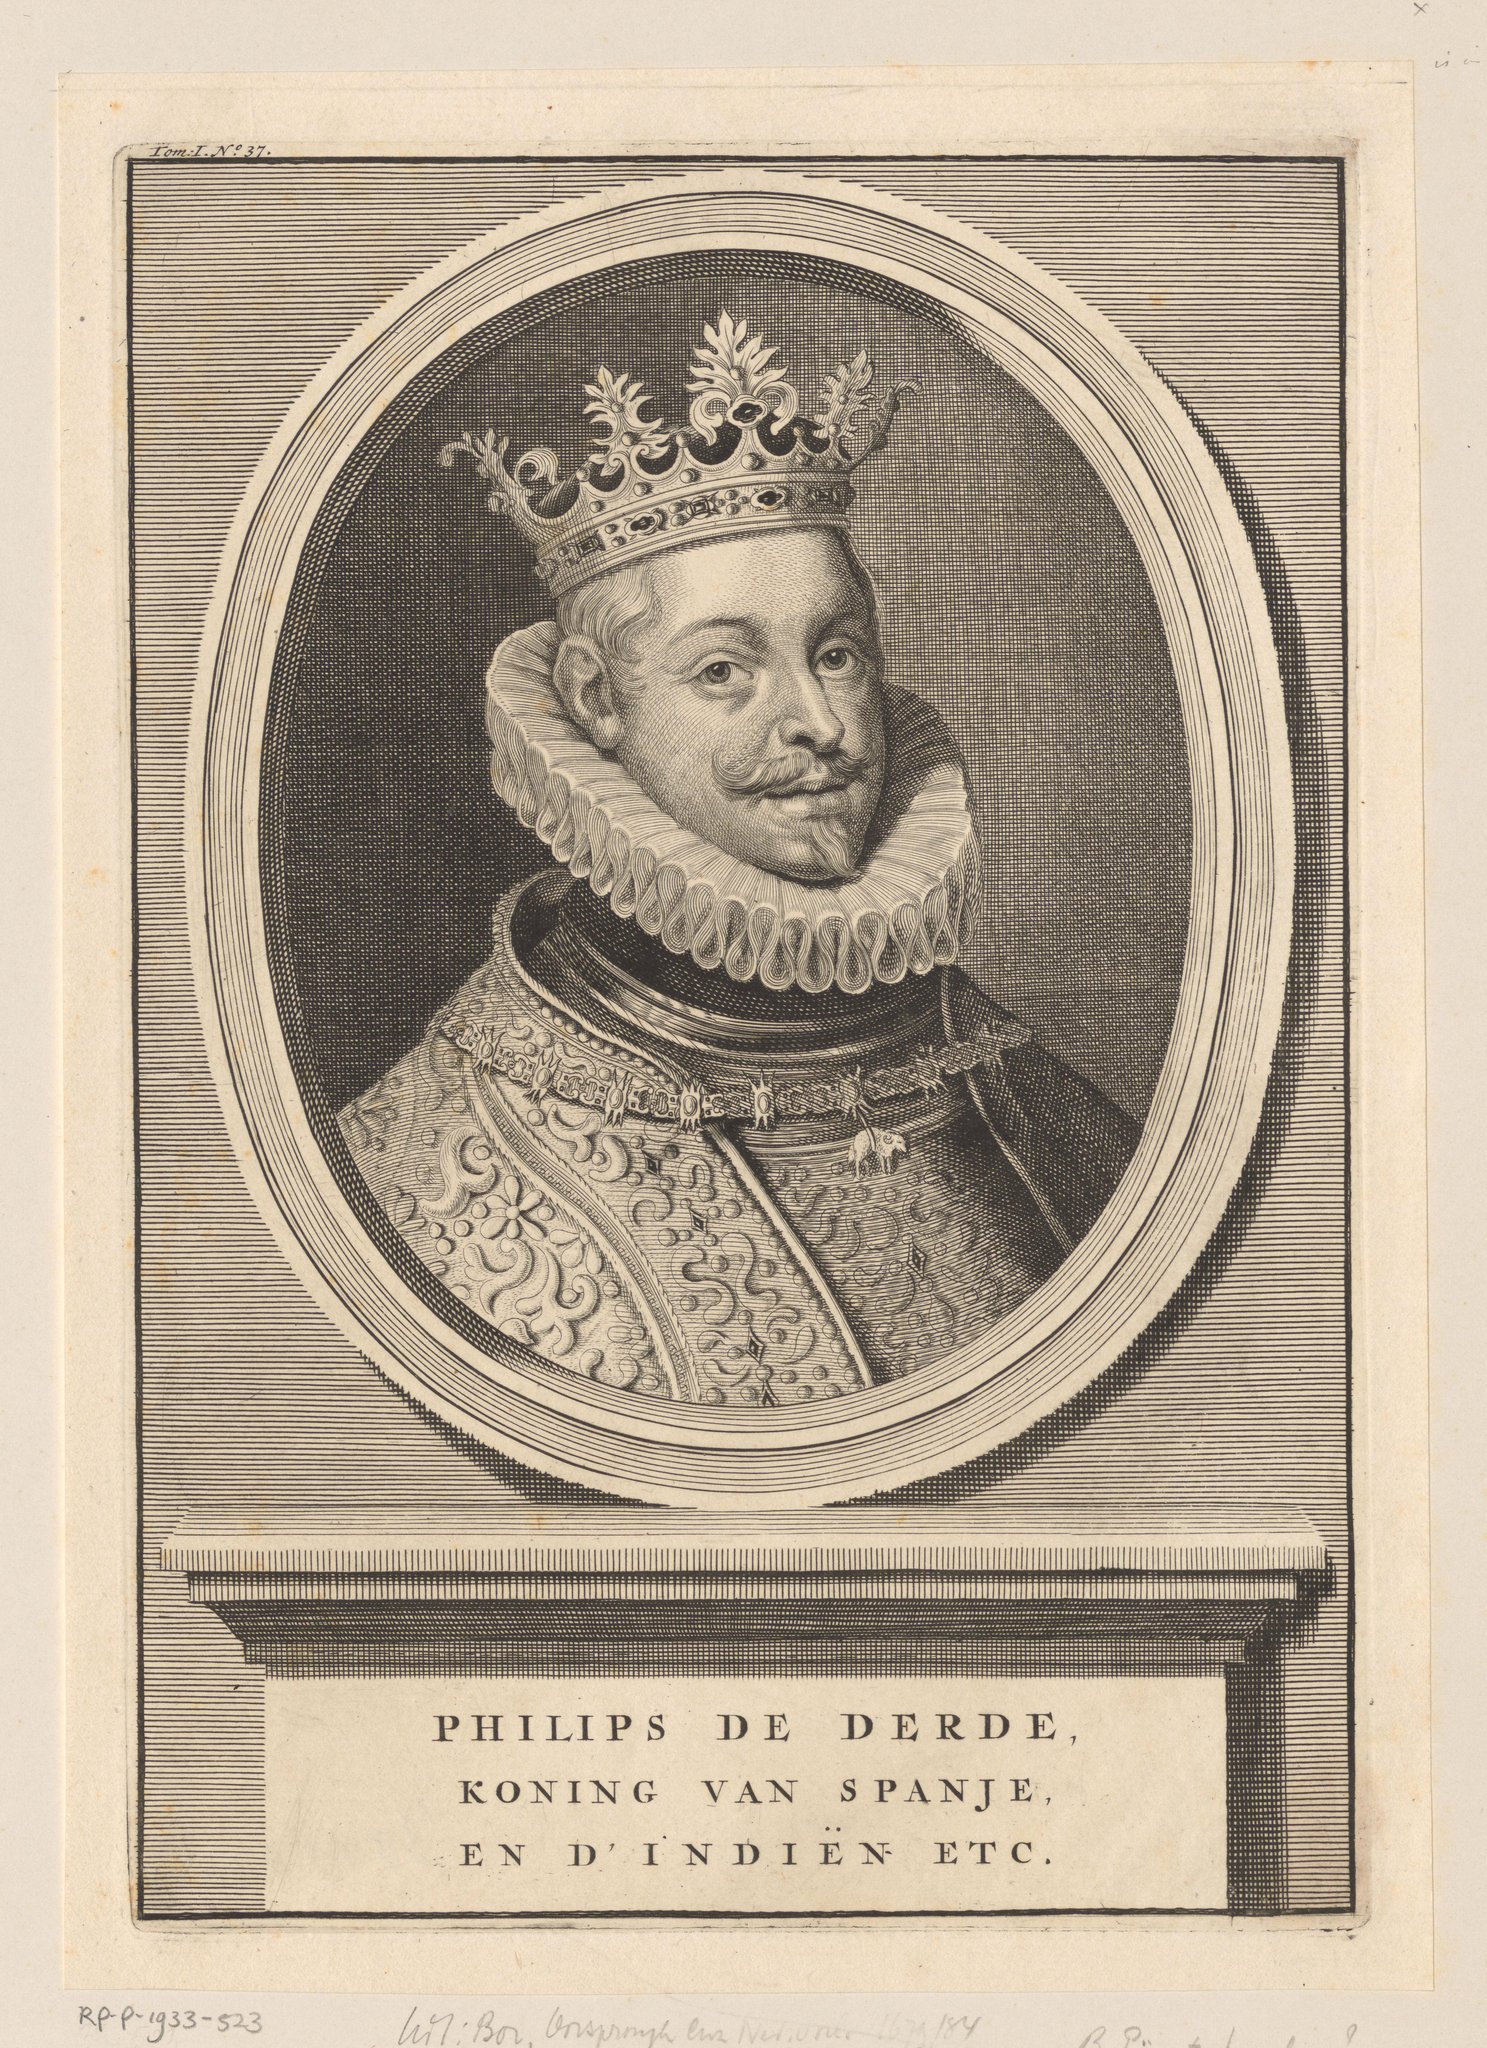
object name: print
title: Portret van Filips III, koning van Spanje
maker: andries vaillant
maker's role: print maker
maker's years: 1655-1693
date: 1730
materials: paper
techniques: engraving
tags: adult man, historical persons, knighthood order of the golden fleece, insignia and symbols of sovereignty (crown, diadem, sceptre, orb, seal, standard, cloak, pectoral)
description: Prent mogelijk uit: Clerc, Jean le. Geschiedenissen der Vereenigde Nederlanden, sedert den aanvang van die republiek tot op den vrede van Utrecht in 't jaar 1713 en het Tractaat van Barriere in't jaar 1715 gesloten. Amsterdam: Zacharias Chatelain, 1730. Andere staat gebruikt in: Bor, Pieter. Oorsprongk, begin, en vervolgh der Nederlandsche oorlogen (...). Amsterdam: weduwe Johannes van Someren, Abraham Wolfgangh, Hendrick en de weduwe van Dirck Boom, 1684.